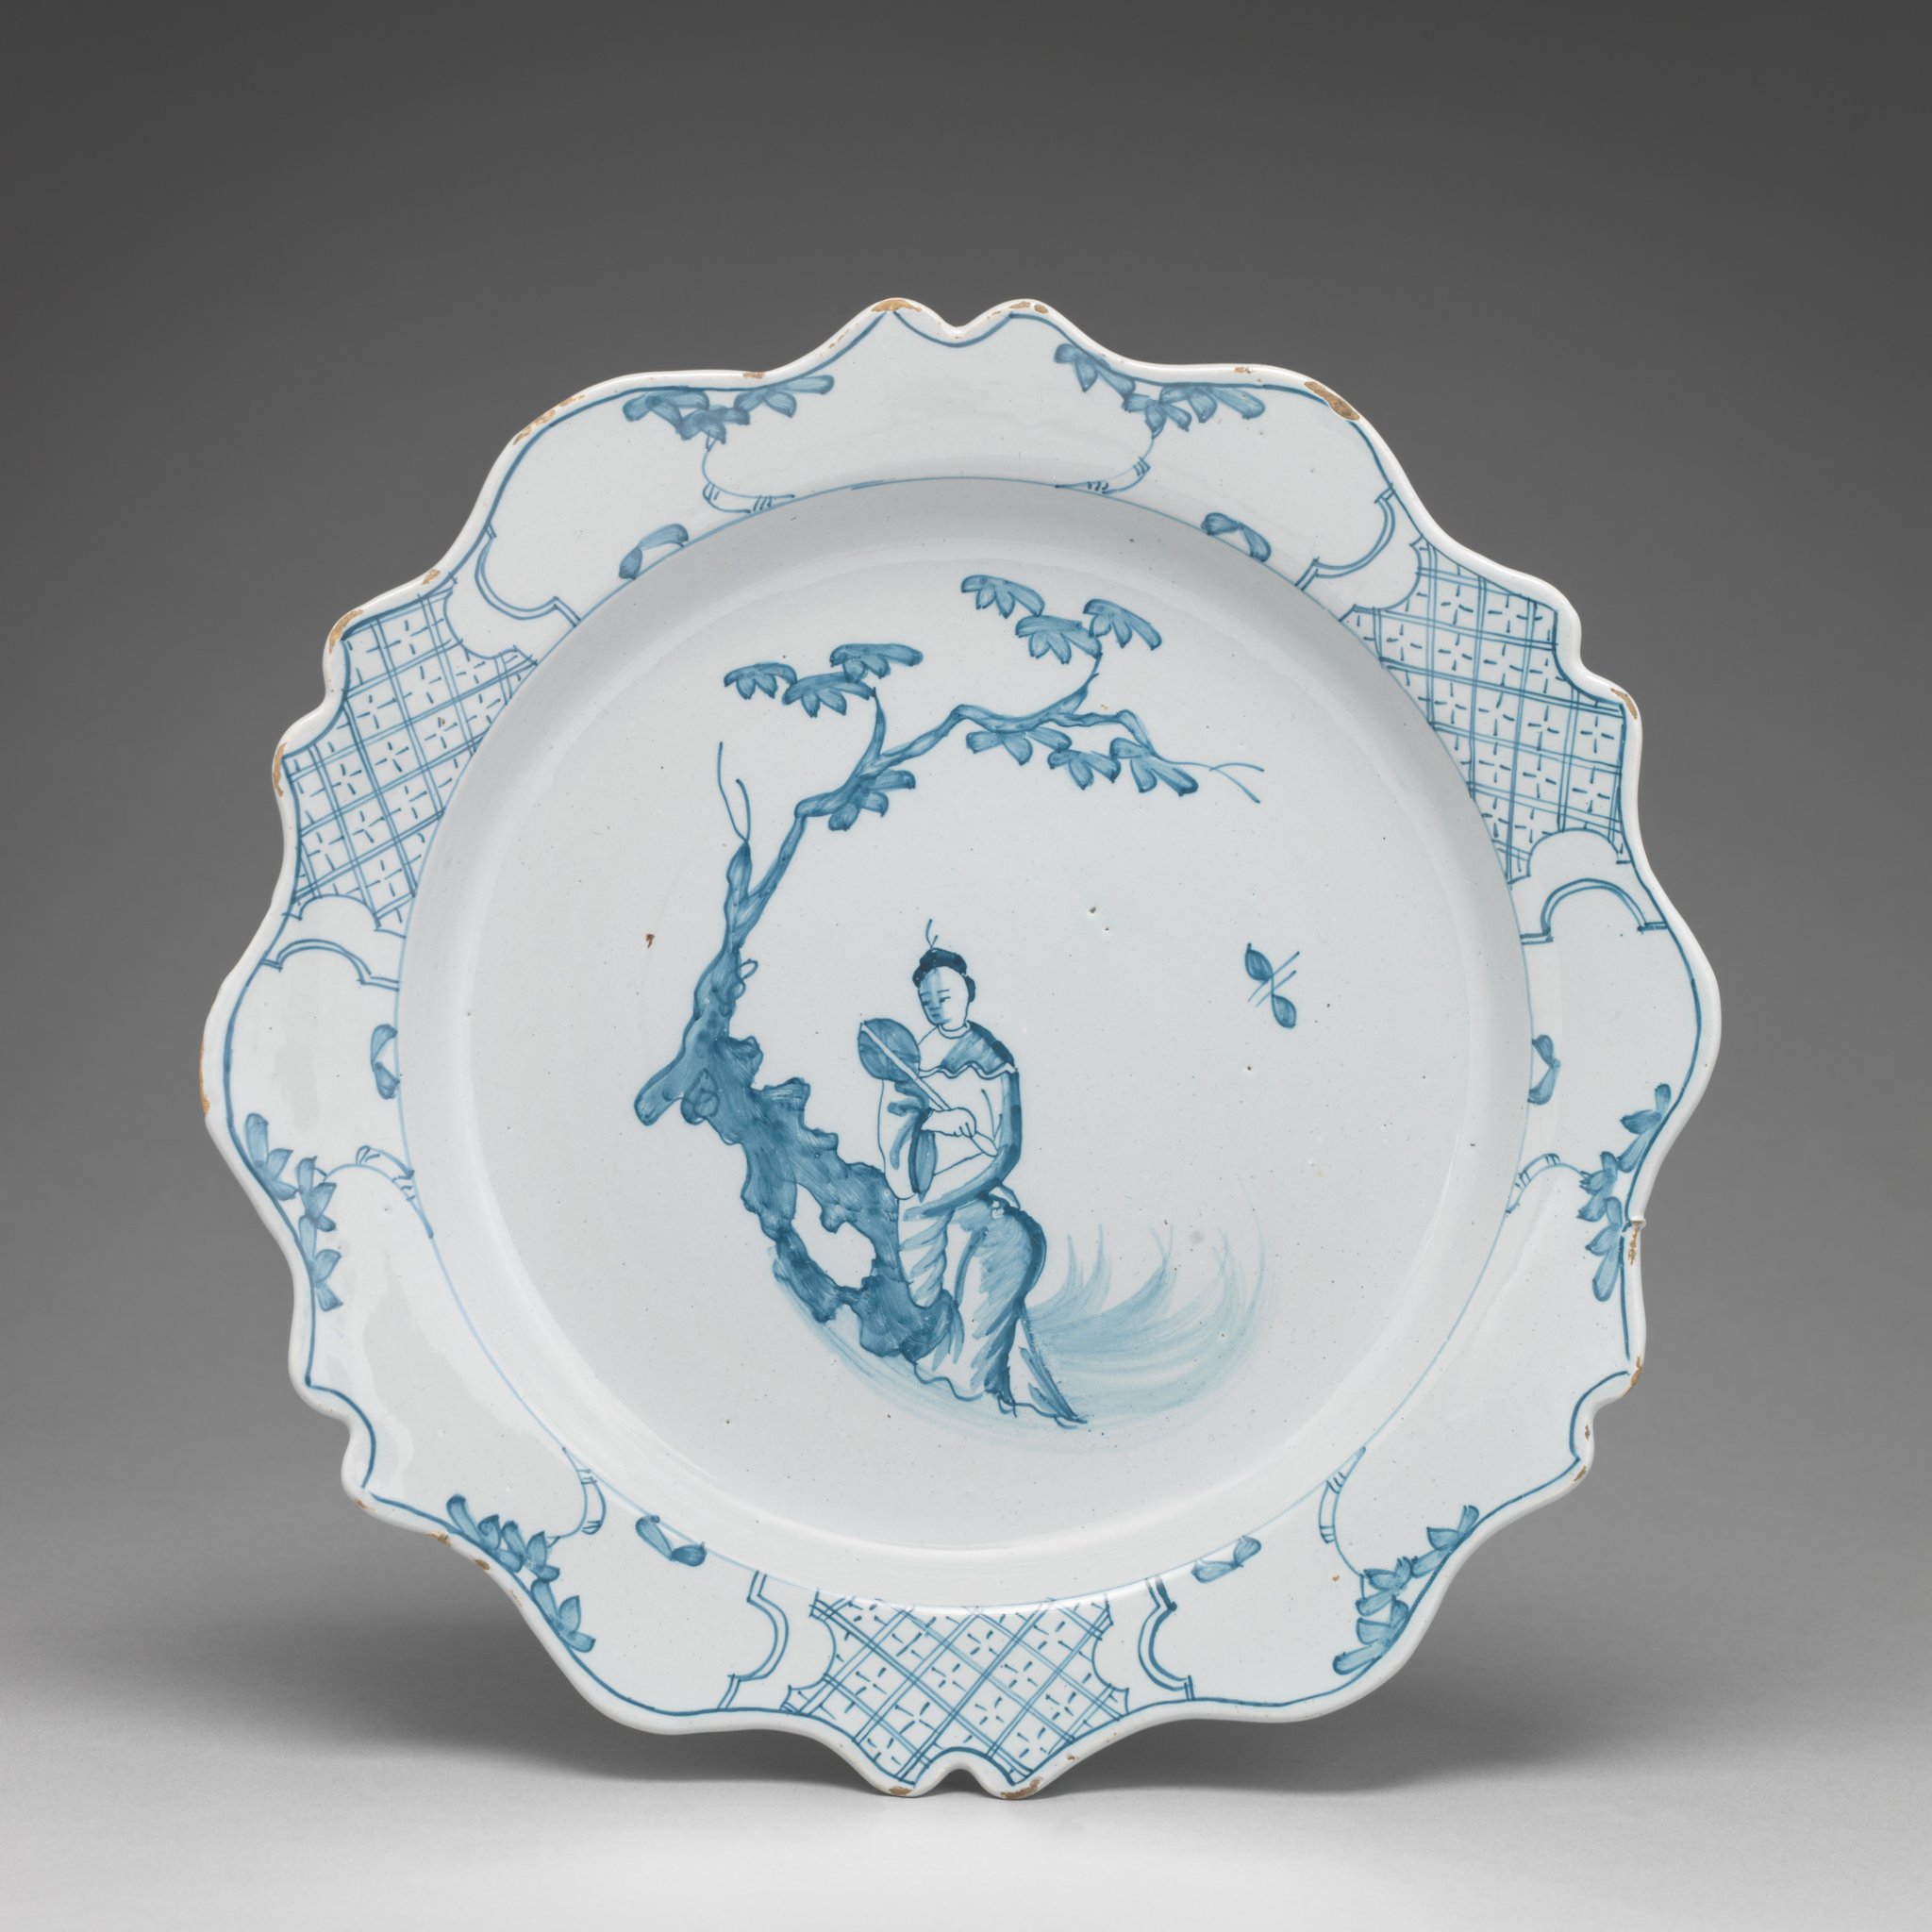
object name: plate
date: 1750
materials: earthenware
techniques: glazing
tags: women